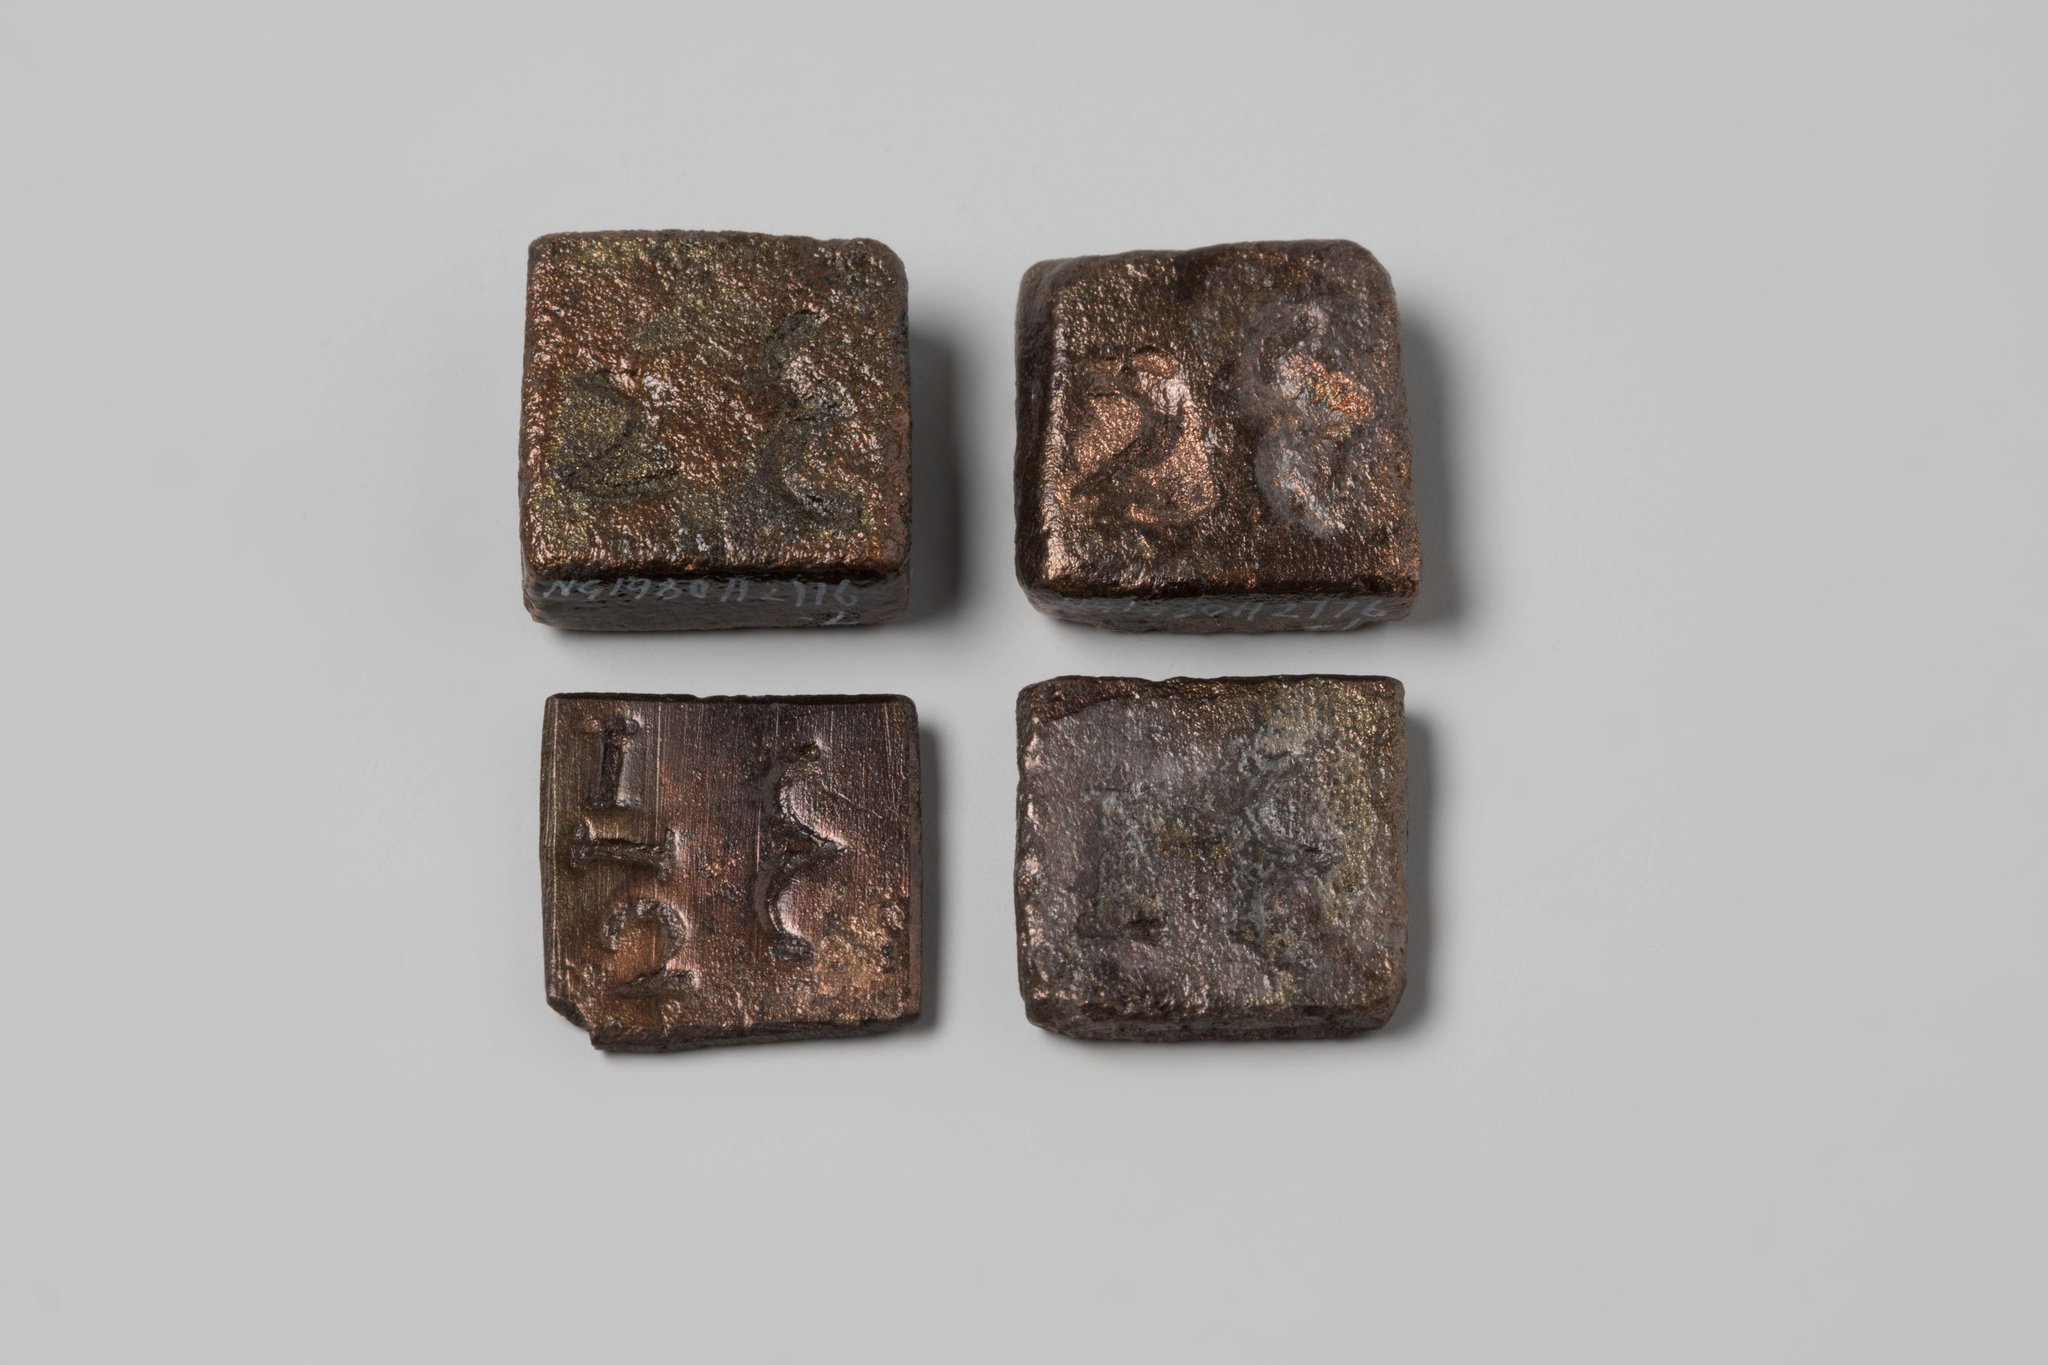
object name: prescription scale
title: Gewichten apothekersbalans uit het wrak van de Oost-Indiëvaarder Hollandia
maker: Anonymous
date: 1700-1743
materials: copper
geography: netherlands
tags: verenigde oostindische compagnie, hollandia (schip), annet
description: Tools and instruments, medical, apothecaries' weight; id. NG 1980-27H2750 drachms, eroded.